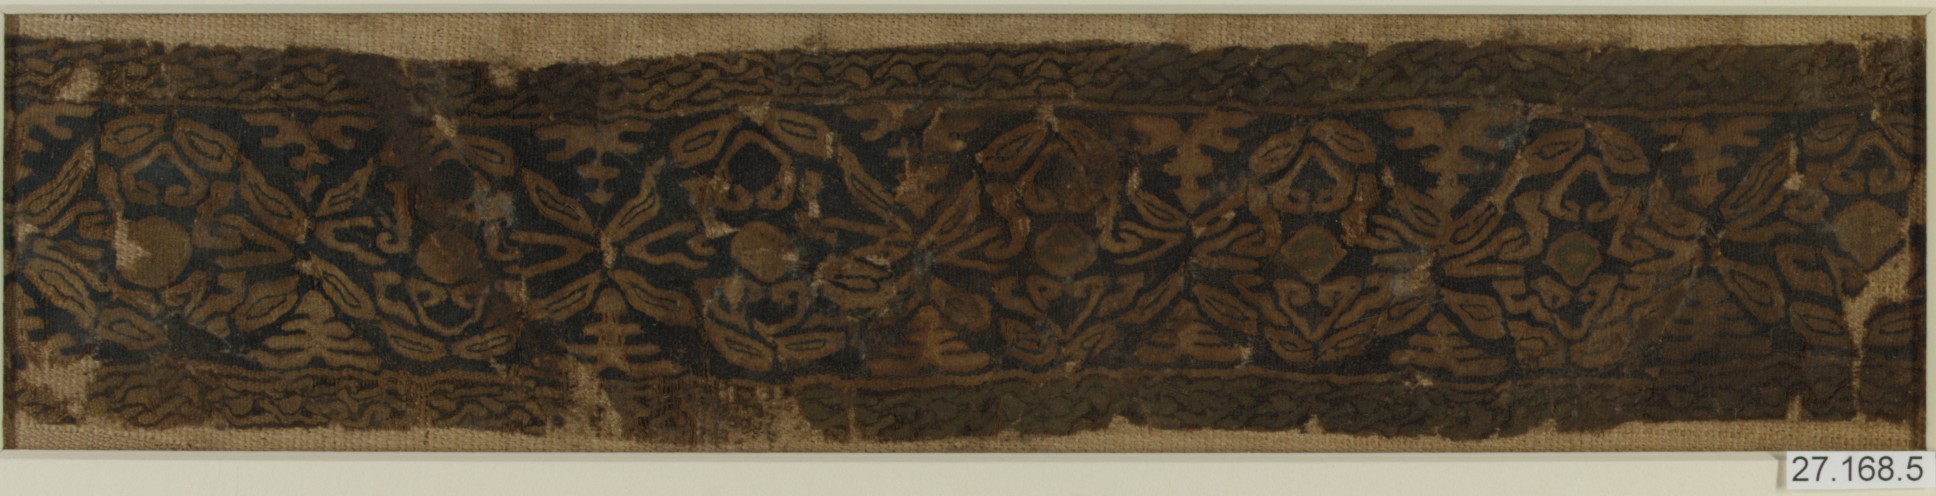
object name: band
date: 901-1100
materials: linen, silk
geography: egypt